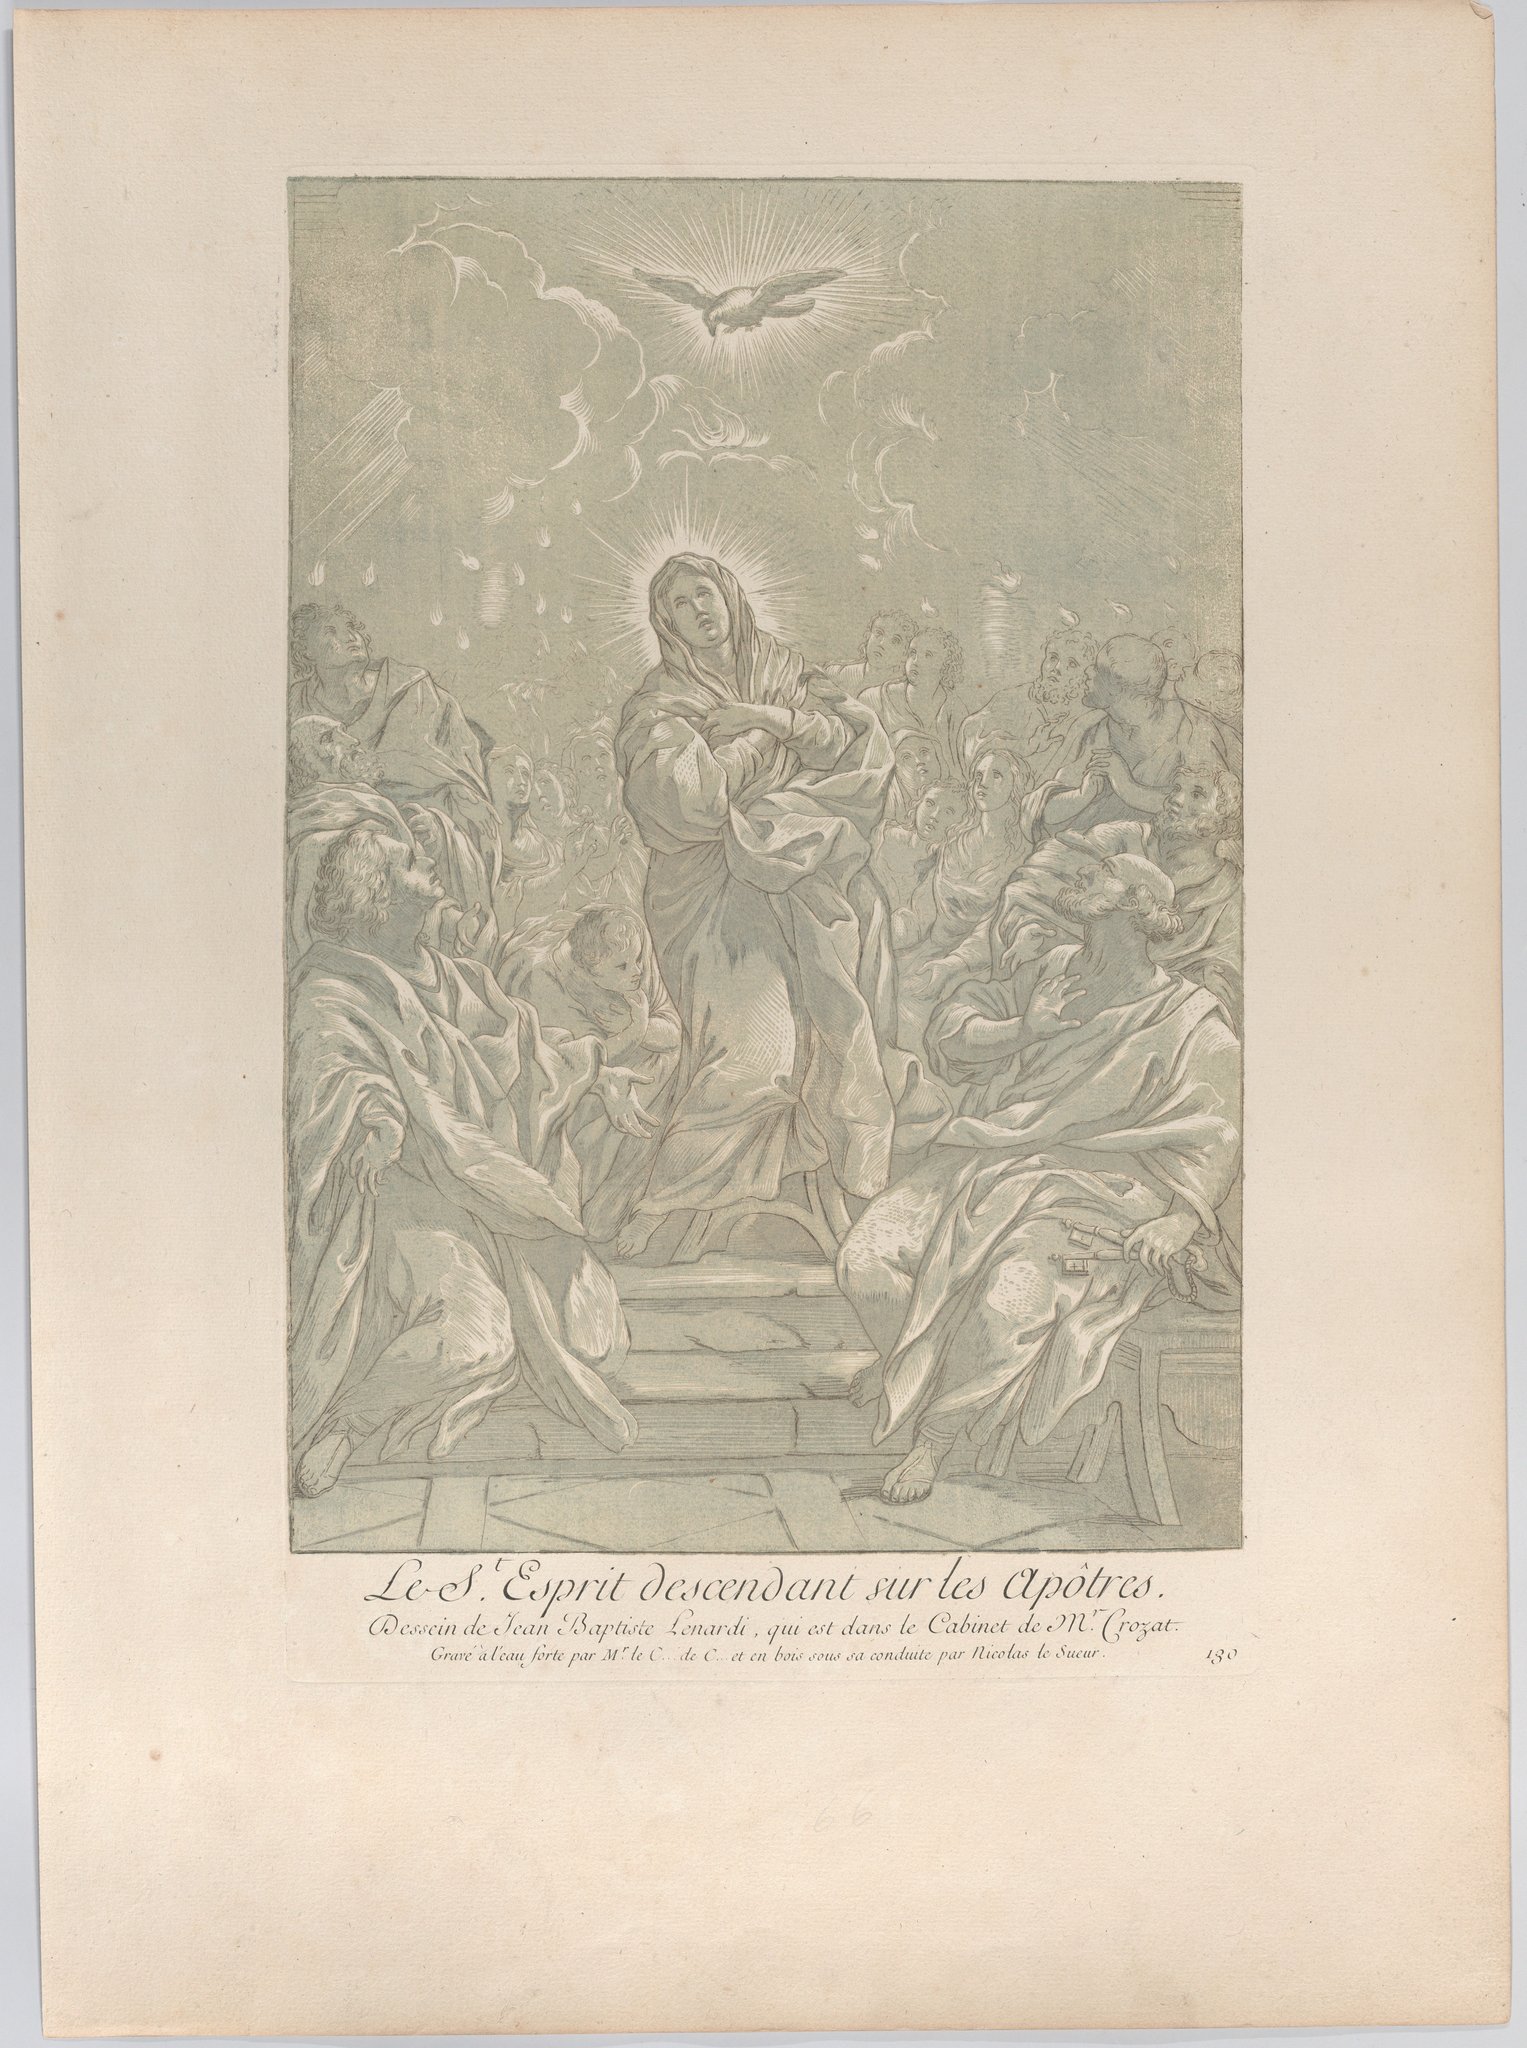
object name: print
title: The Pentecost, with the Virgin standing at center, the Holy Spirit above, and Apostles on both sides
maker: anne claude philippe de tubières, comte de caylus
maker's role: artist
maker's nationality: french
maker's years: 1692-1765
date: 1729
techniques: aquatint, etching